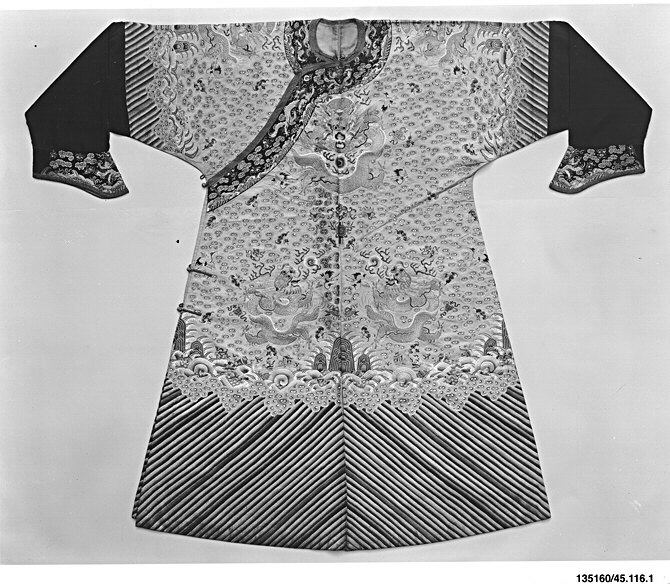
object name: robe, imperial court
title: Imperial Court Robe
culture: chinese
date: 1821-1850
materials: metal thread, silk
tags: dragons